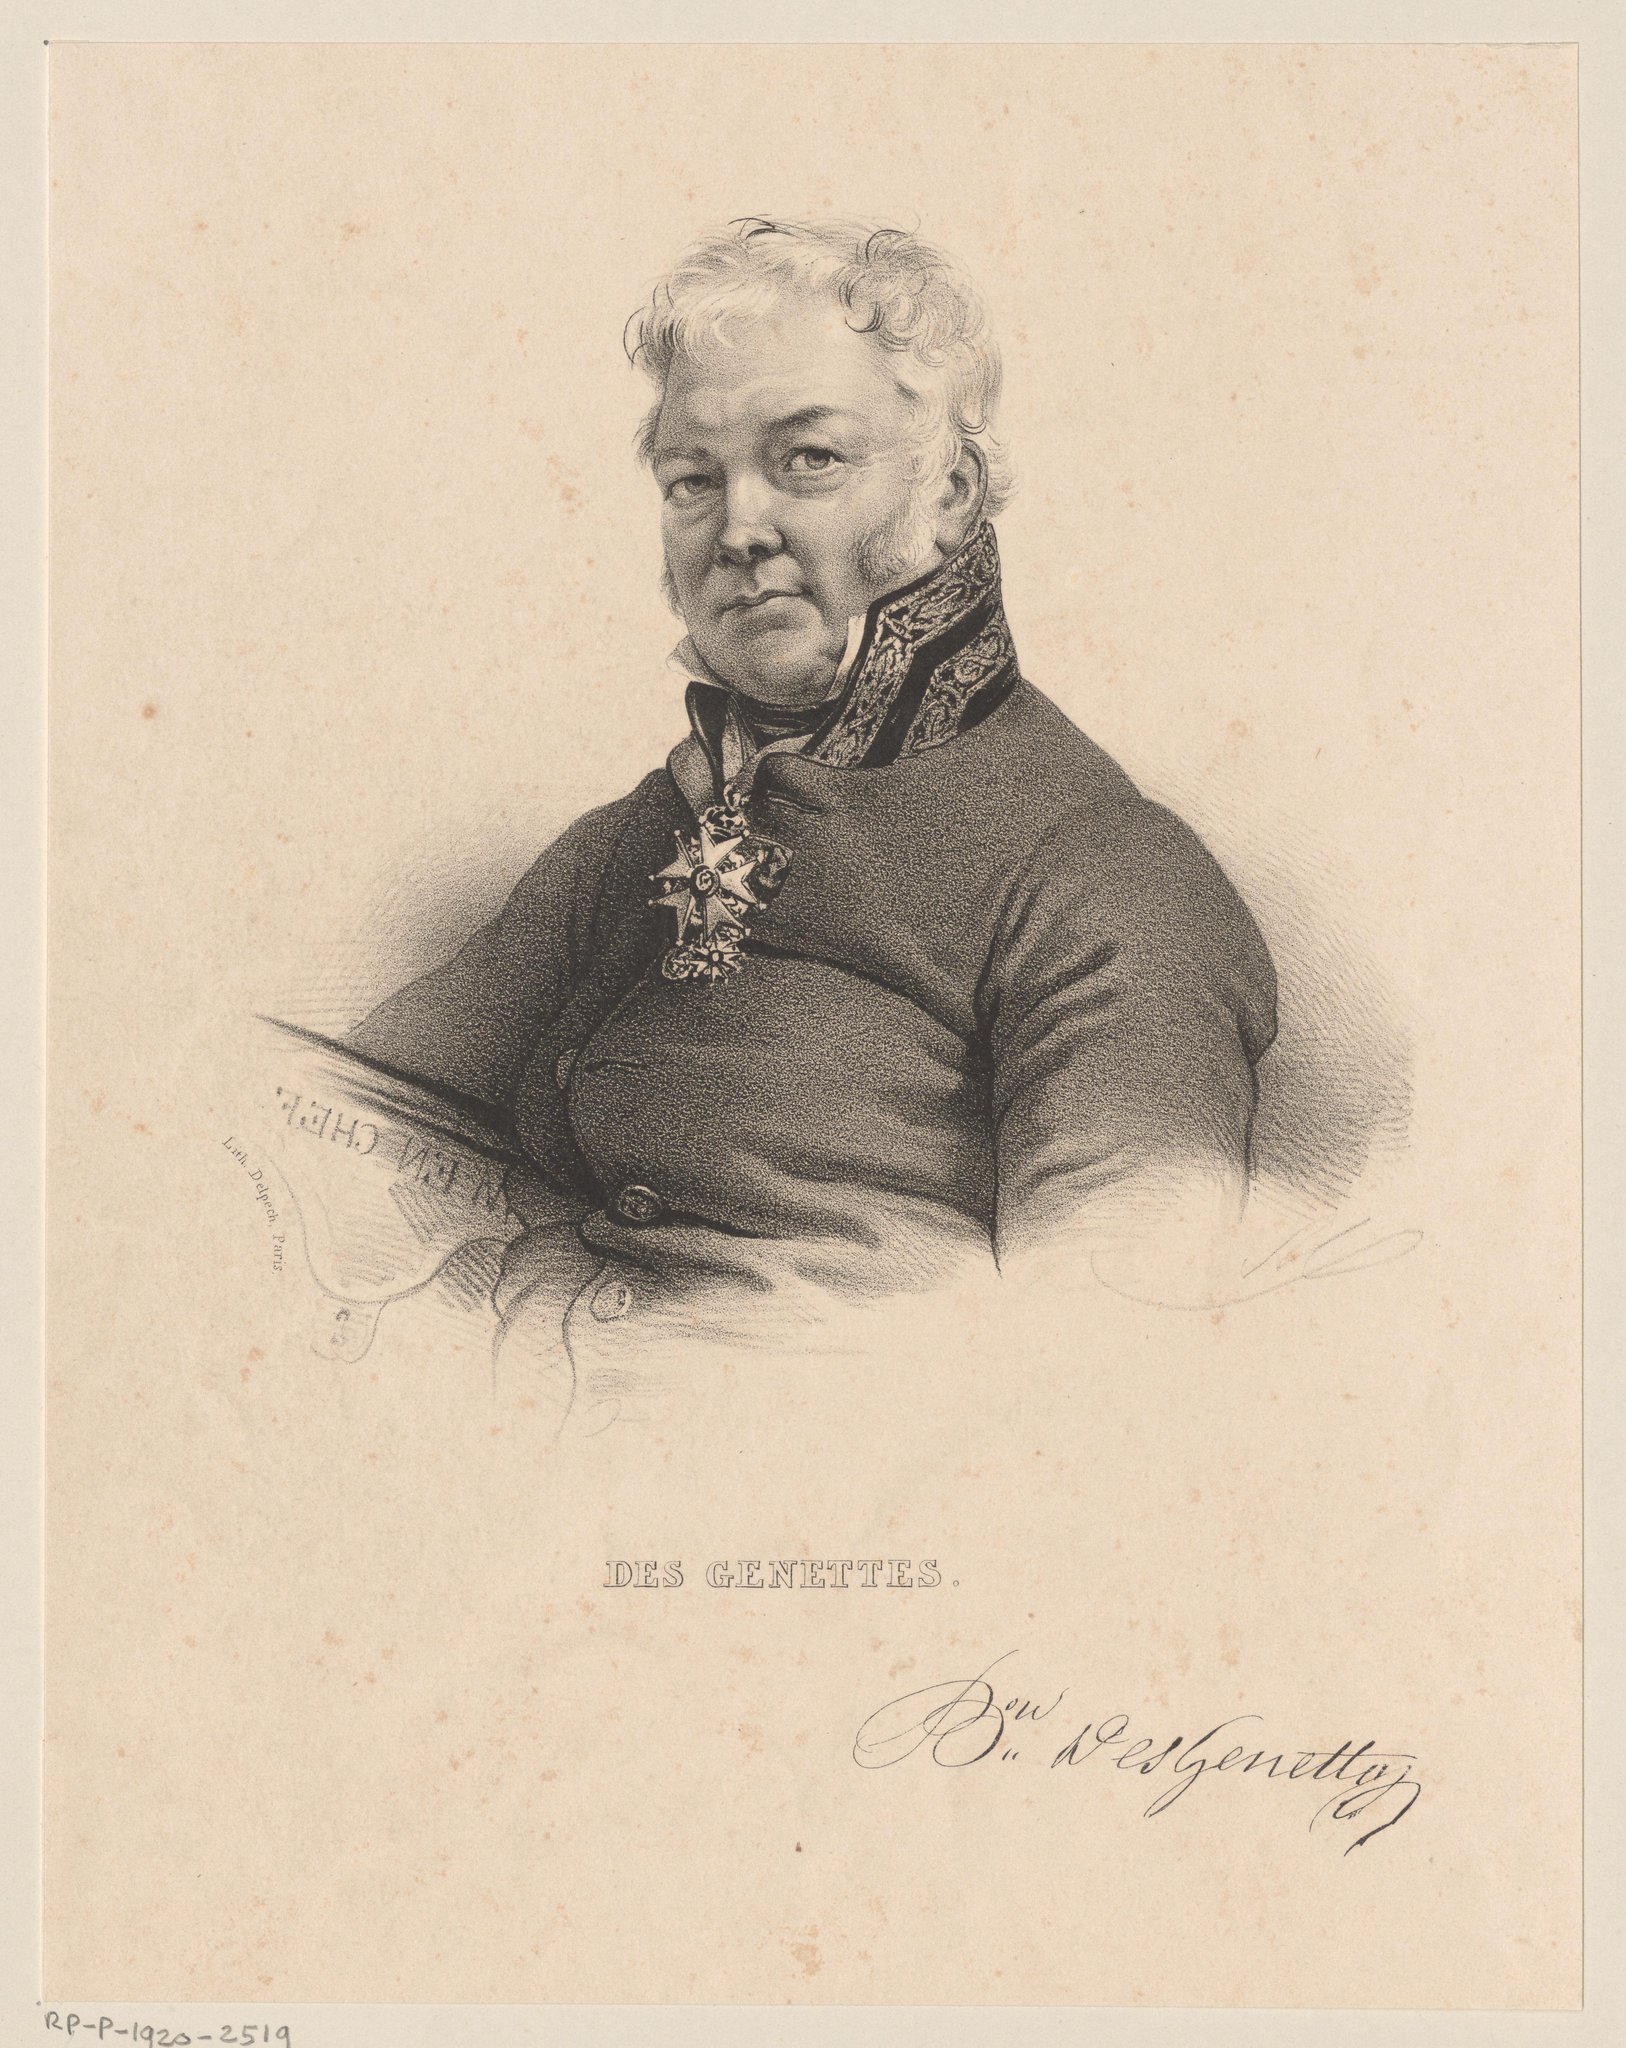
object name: print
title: Portret van René-Nicolas Dufriche Desgenettes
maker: nicolas maurin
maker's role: painter, print maker, printer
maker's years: 1798-1850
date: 1818-1842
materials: paper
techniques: lithograph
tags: historical persons, physician, doctor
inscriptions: collector's mark: Lugt 2228